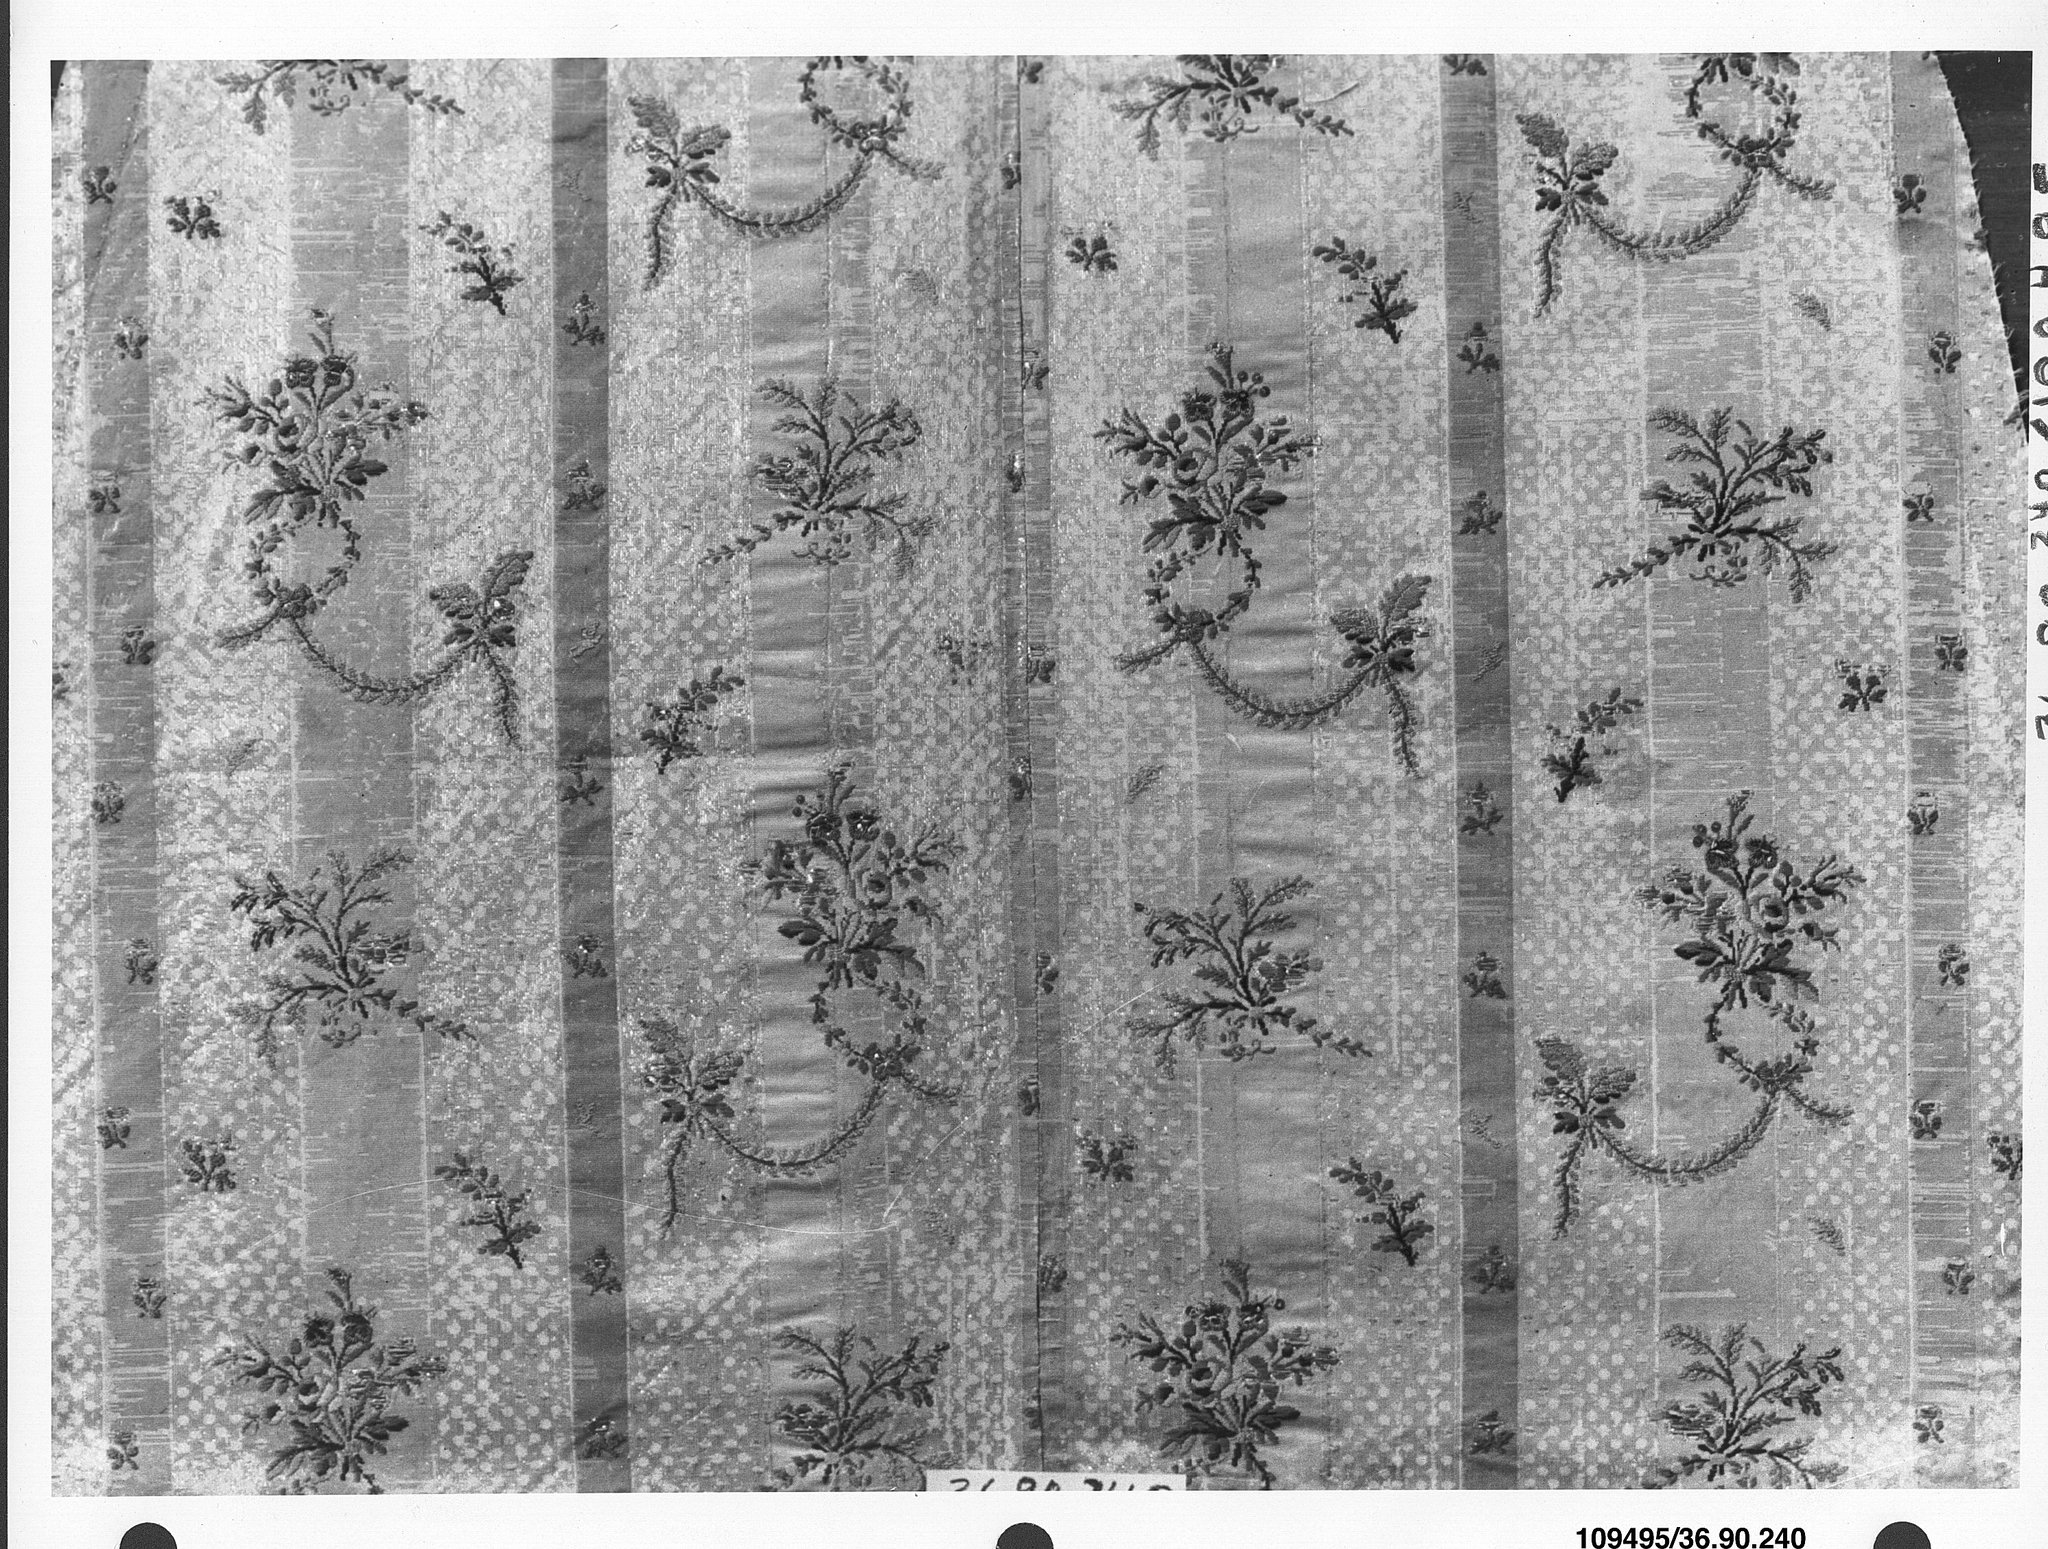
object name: piece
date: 1701-1800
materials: metal thread, silk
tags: flowers